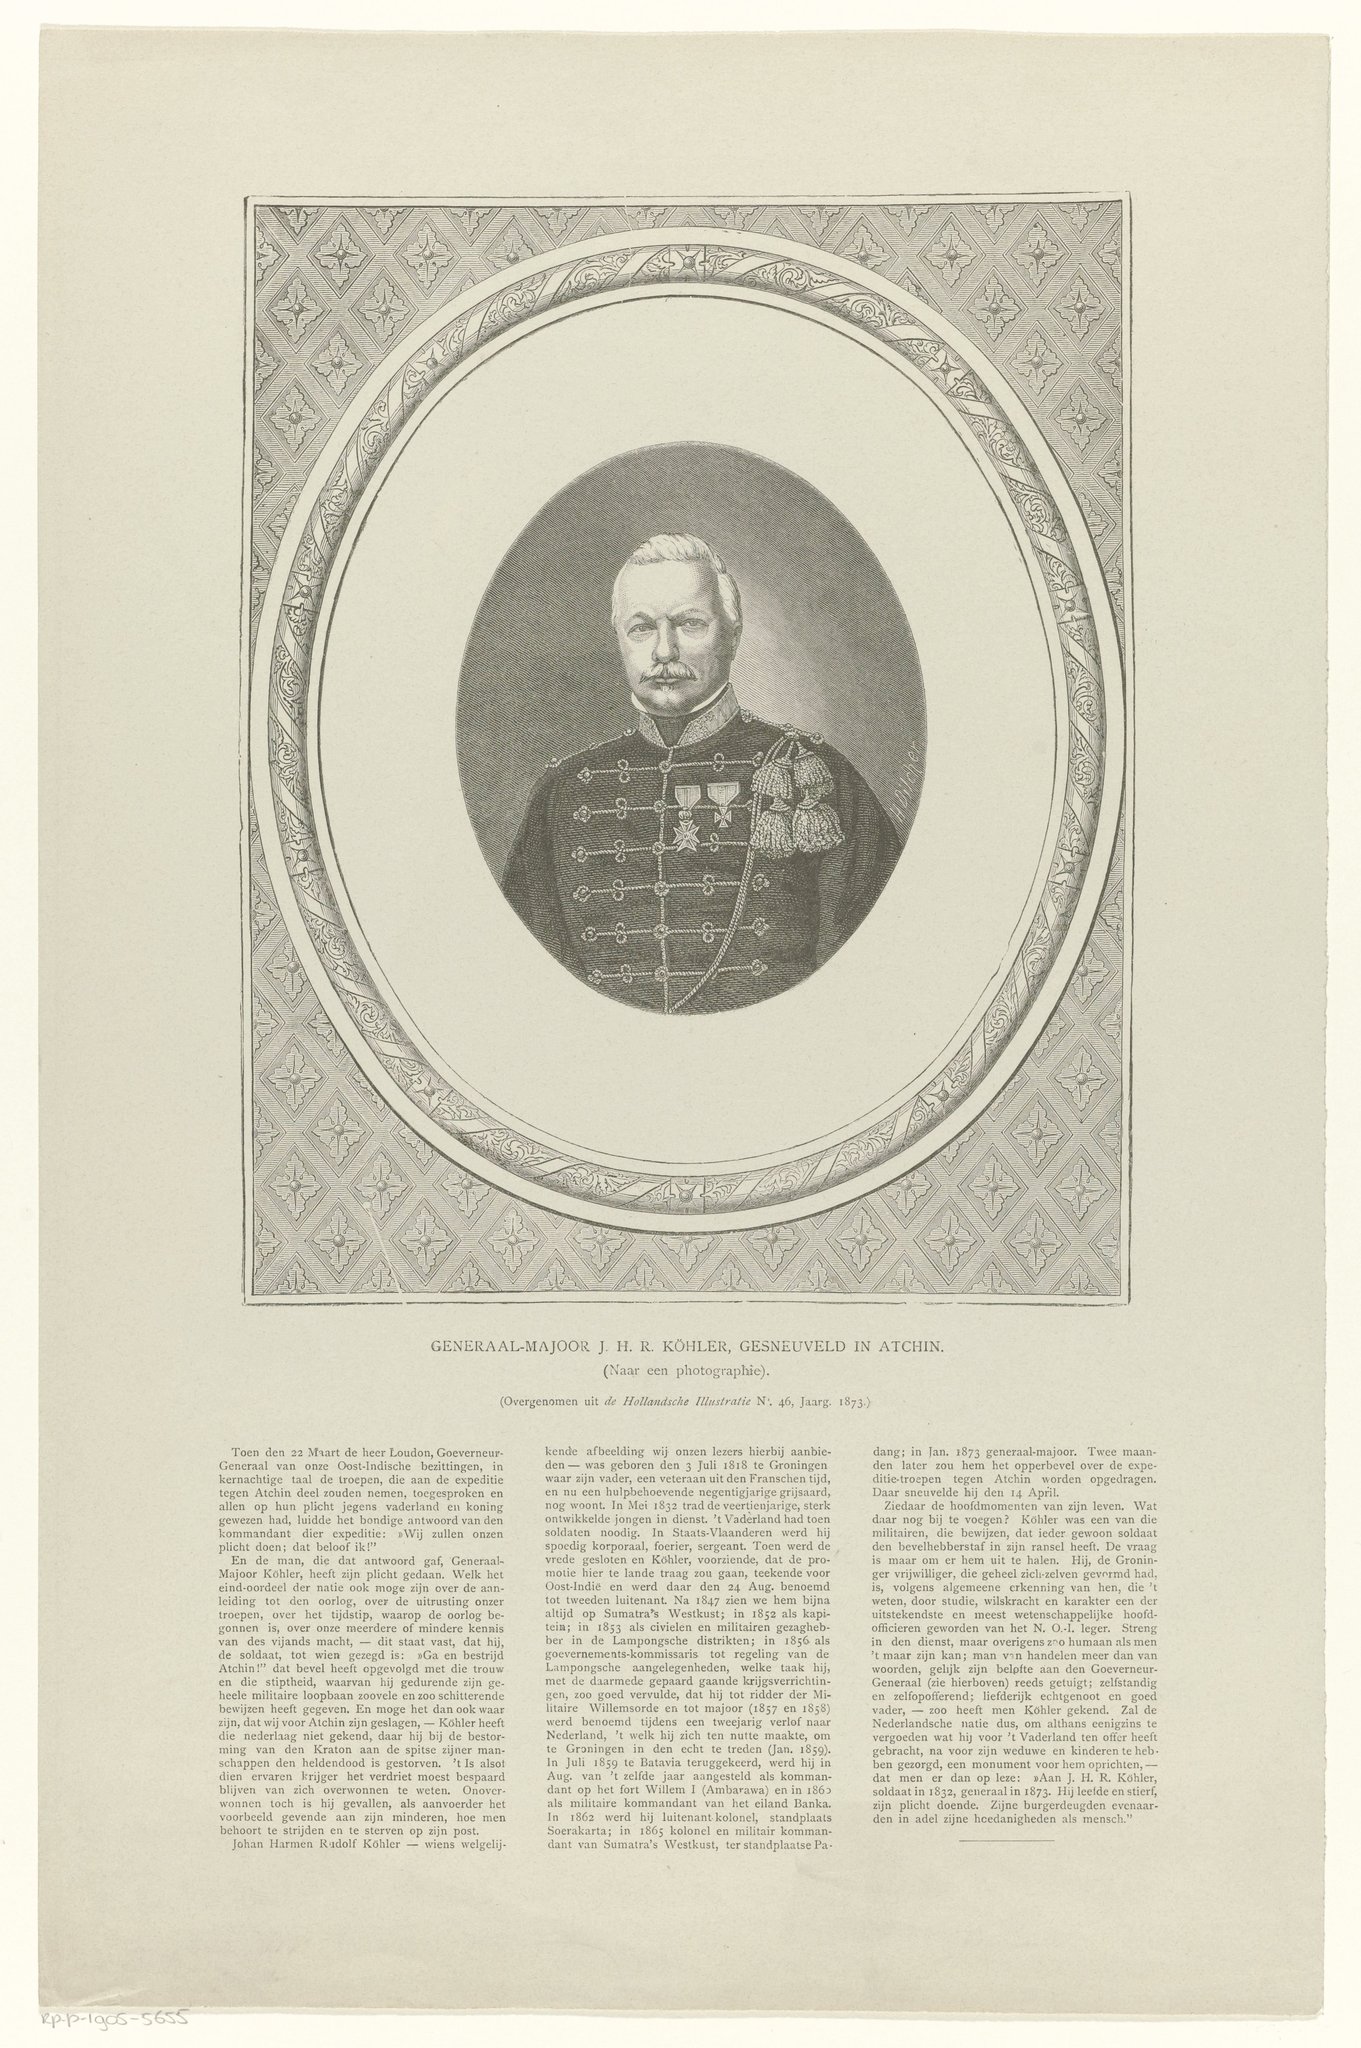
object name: print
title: Portret van generaal-majoor Johan Harmen Rudolf Köhler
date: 1873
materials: paper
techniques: letterpress printing, engraving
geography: amsterdam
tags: generaal-majoor, johan harmen rudolf köhler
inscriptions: collector's mark: Lugt 2228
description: Portret van generaal-majoor Johan Harmen Rudolf Köhler in een geornamenteerd ovaal. In de ondermarge zijn naam, zijn titel en drie kolommen met regels Nederlandse tekst.